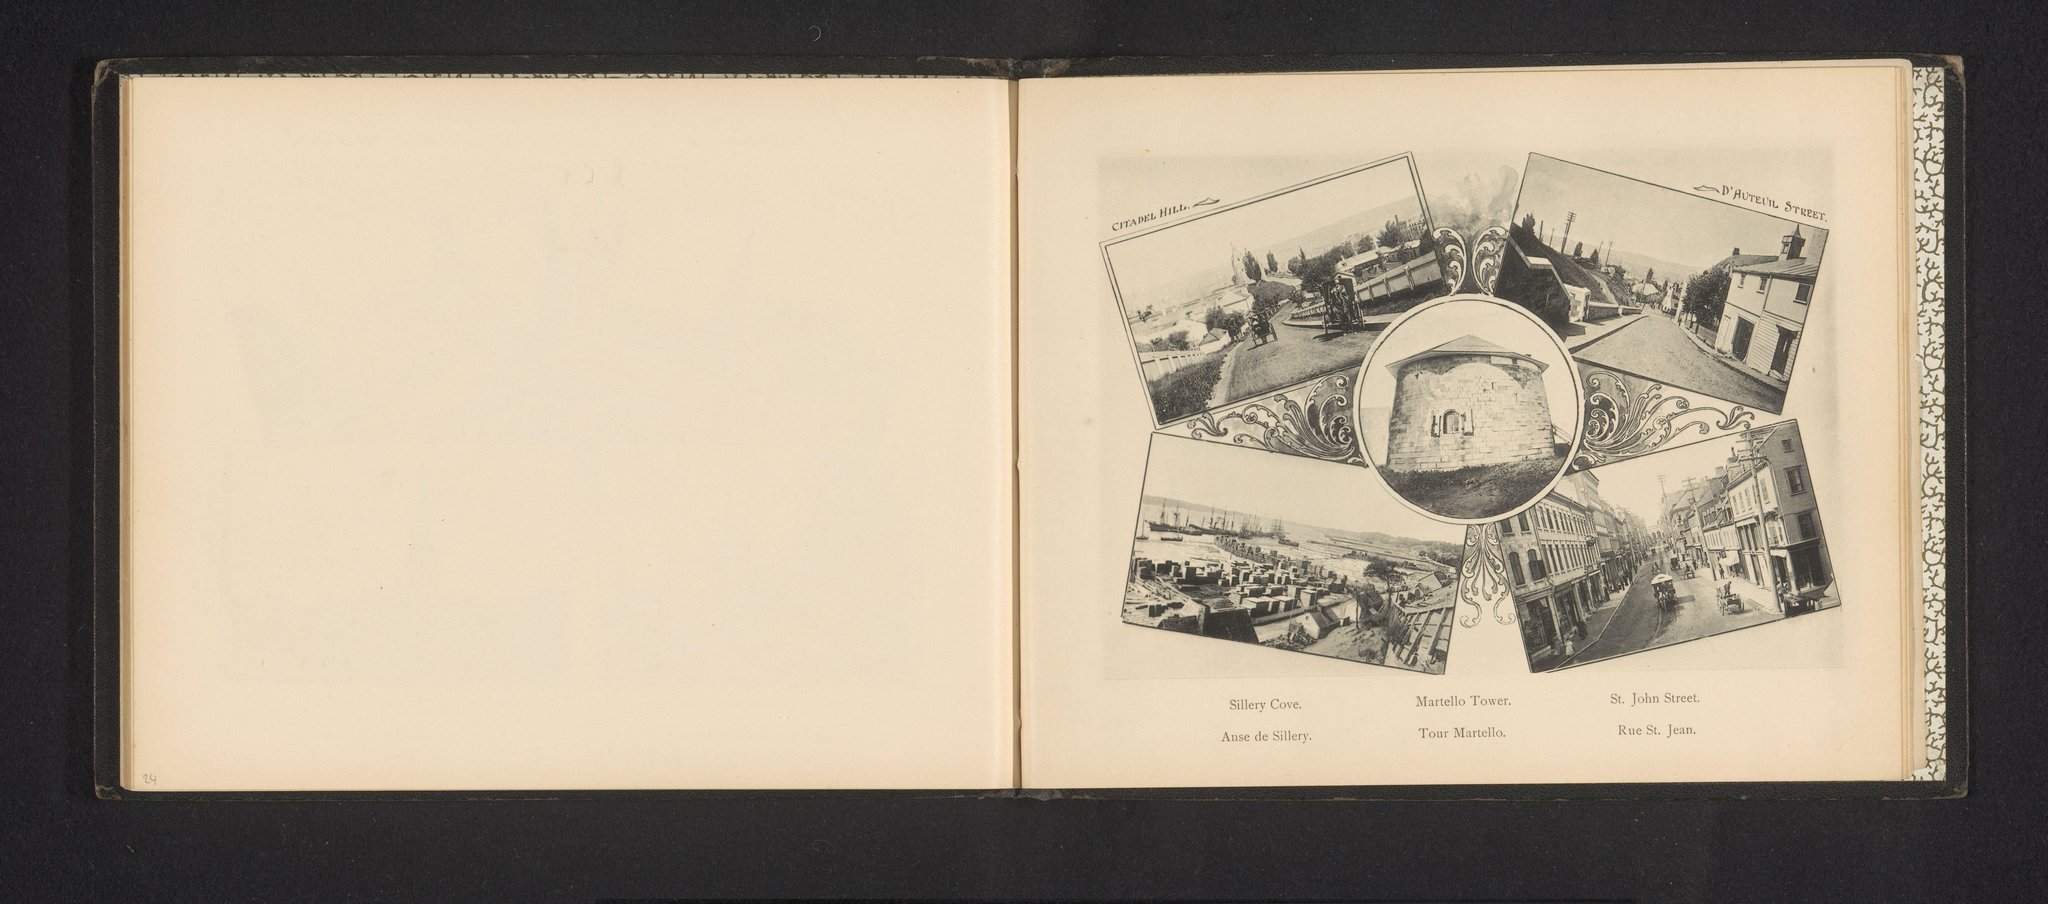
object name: page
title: Fotomontage van vijf gezichten in Québec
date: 1889-1894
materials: paper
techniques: photograph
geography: quebec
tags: harbour, city-view in general; 'veduta', street, québec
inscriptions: inscription: ‘Sillery Cove/ Martello Tower/ St. John Street’